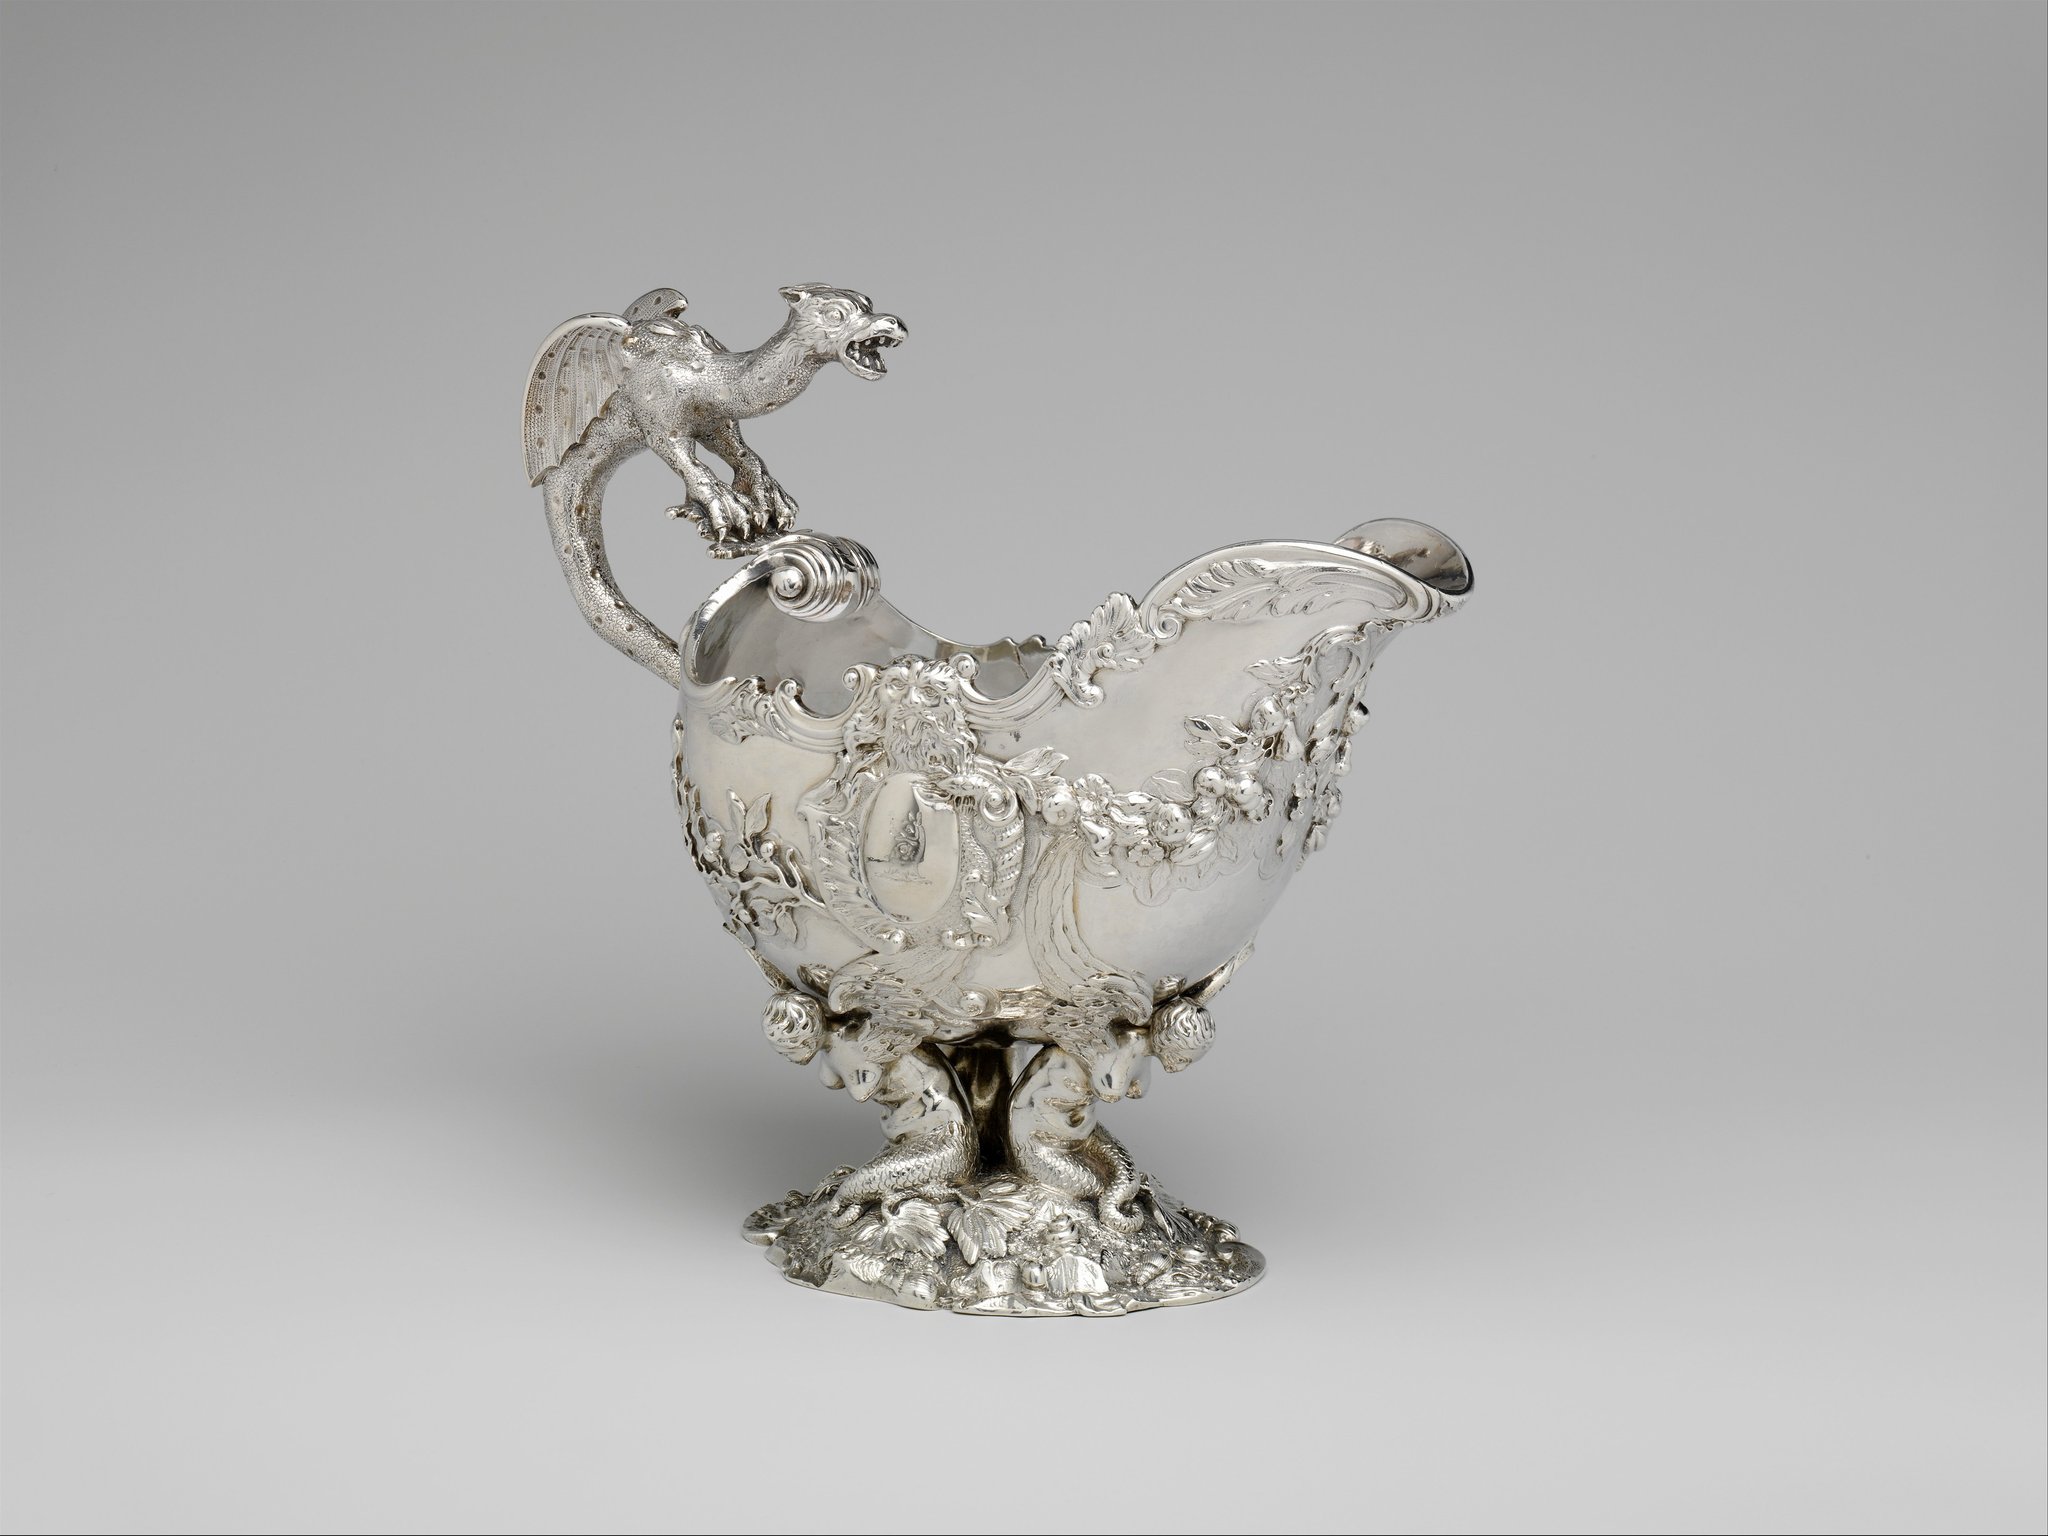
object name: sauceboat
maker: charles frederich kandler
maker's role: maker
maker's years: 1678-1778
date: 1742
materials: silver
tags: dragons,mermaids